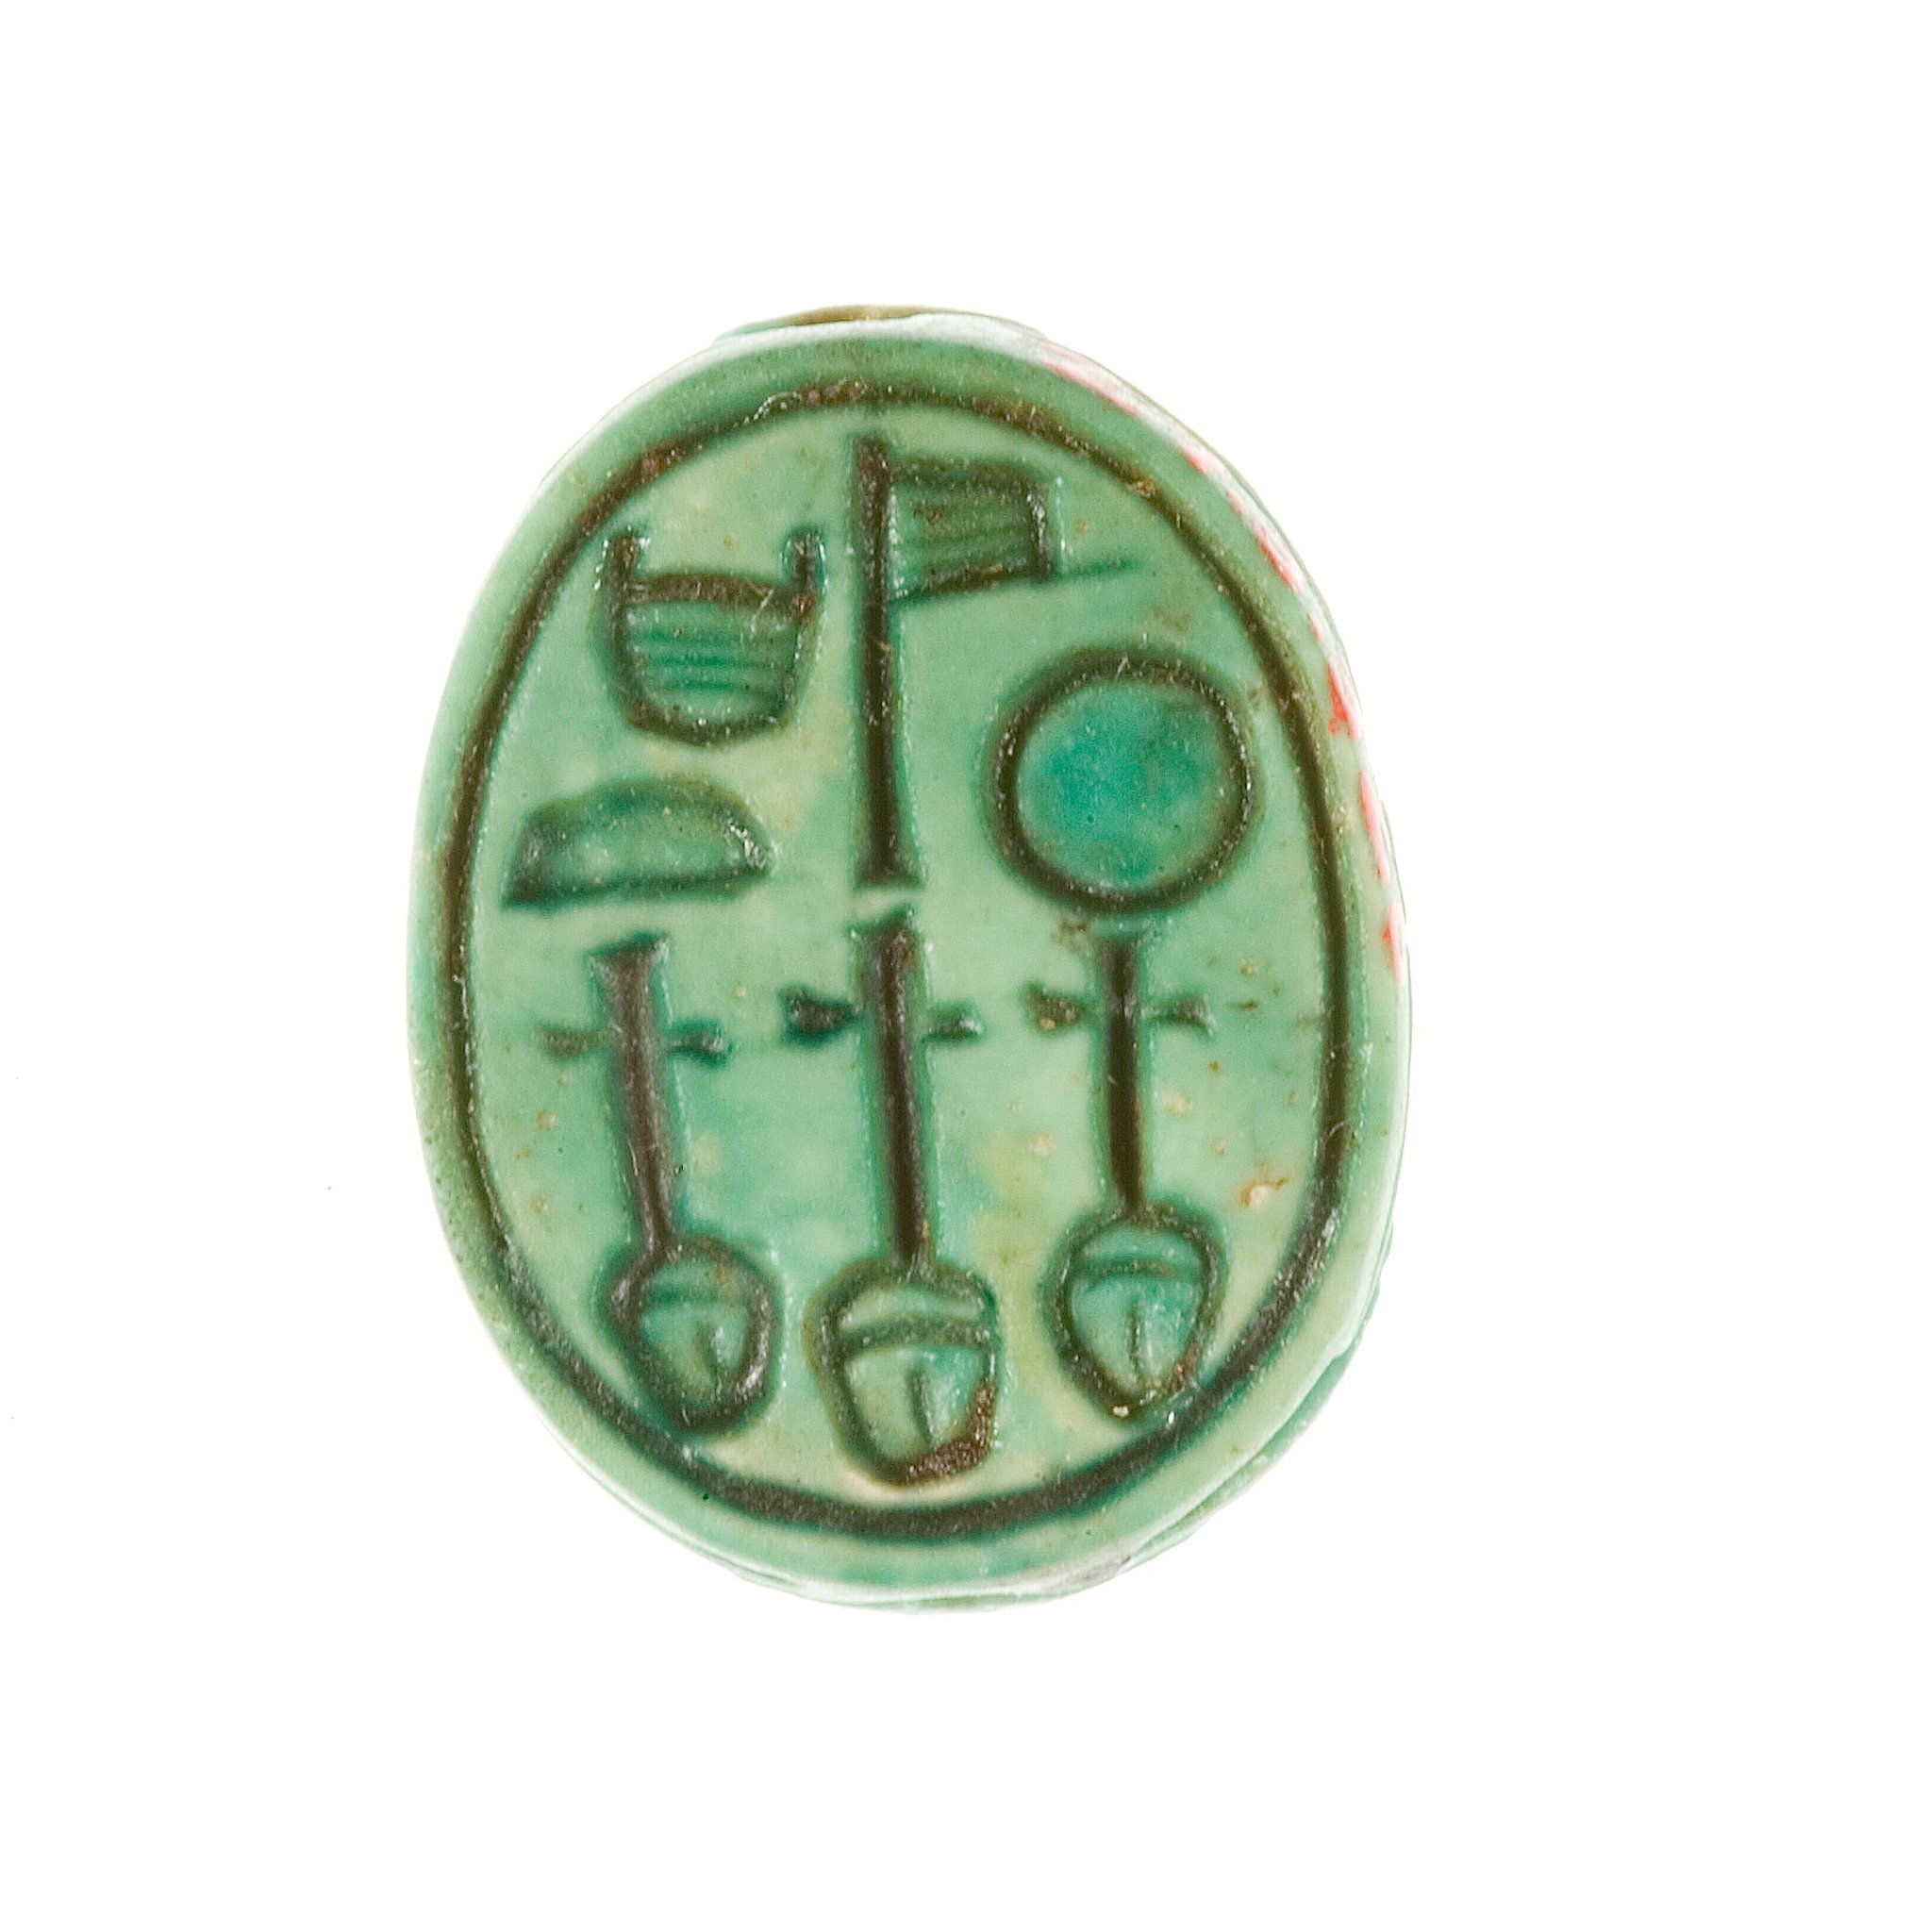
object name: scarab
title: Scarab Inscribed for the God's Wife Neferure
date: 1479-1458 BCE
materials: stone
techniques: glazing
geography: egypt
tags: scarabs